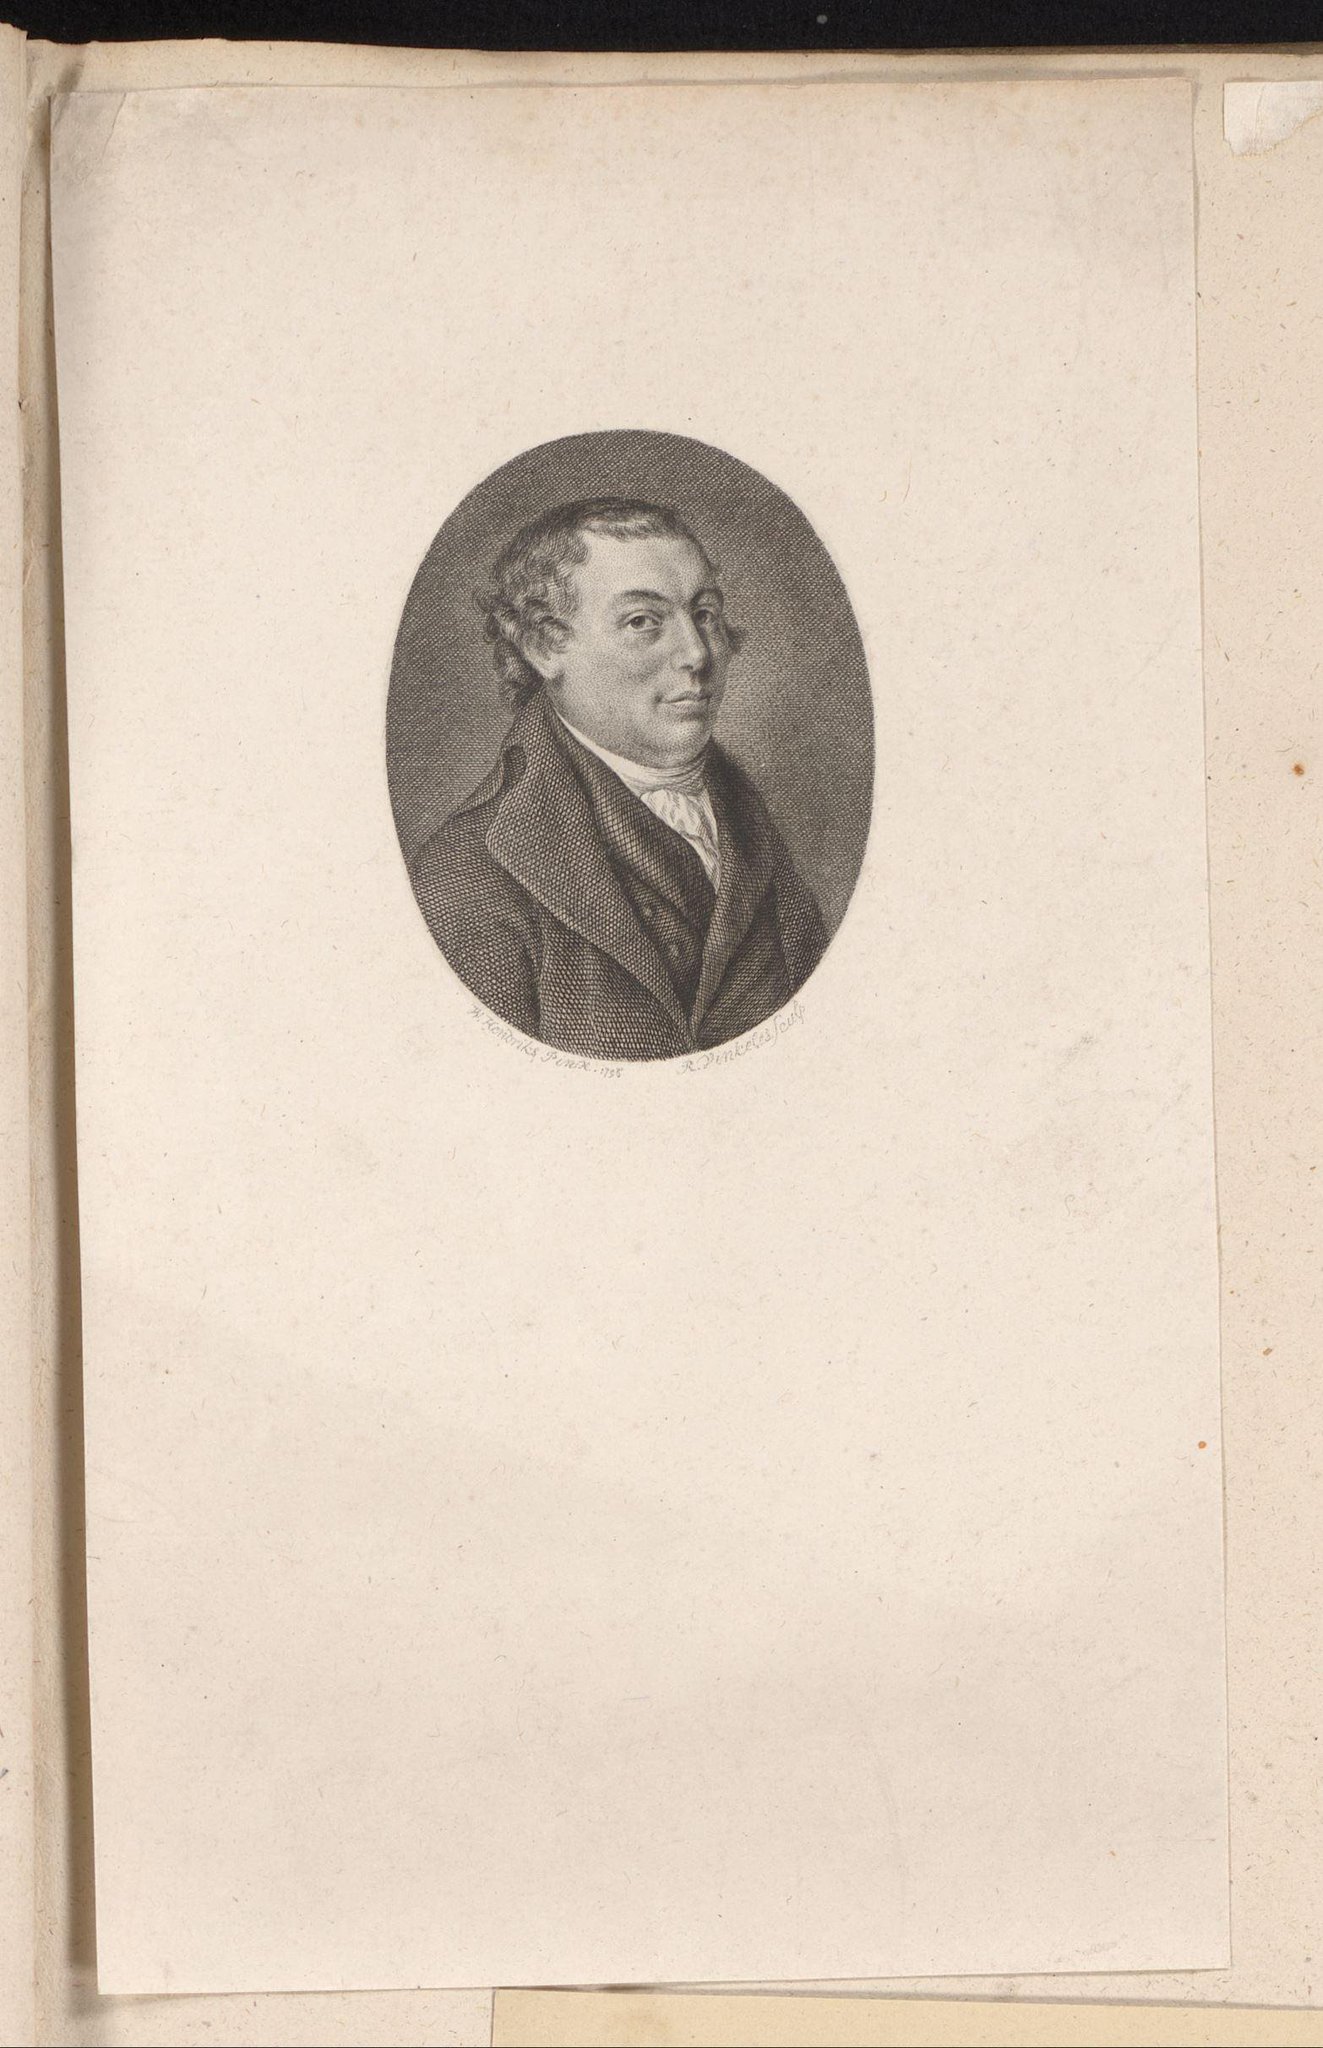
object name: print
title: Portret van Adriaan Pietersz. Loosjes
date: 1796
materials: paper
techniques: engraving, etching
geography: amsterdam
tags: haarlem, bookseller, adriaan pietersz. loosjes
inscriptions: date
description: Portret van de dichter, schrijver en boekhandelaar Adriaan Pietersz. Loosjes. De prent maakt deel uit van een album.